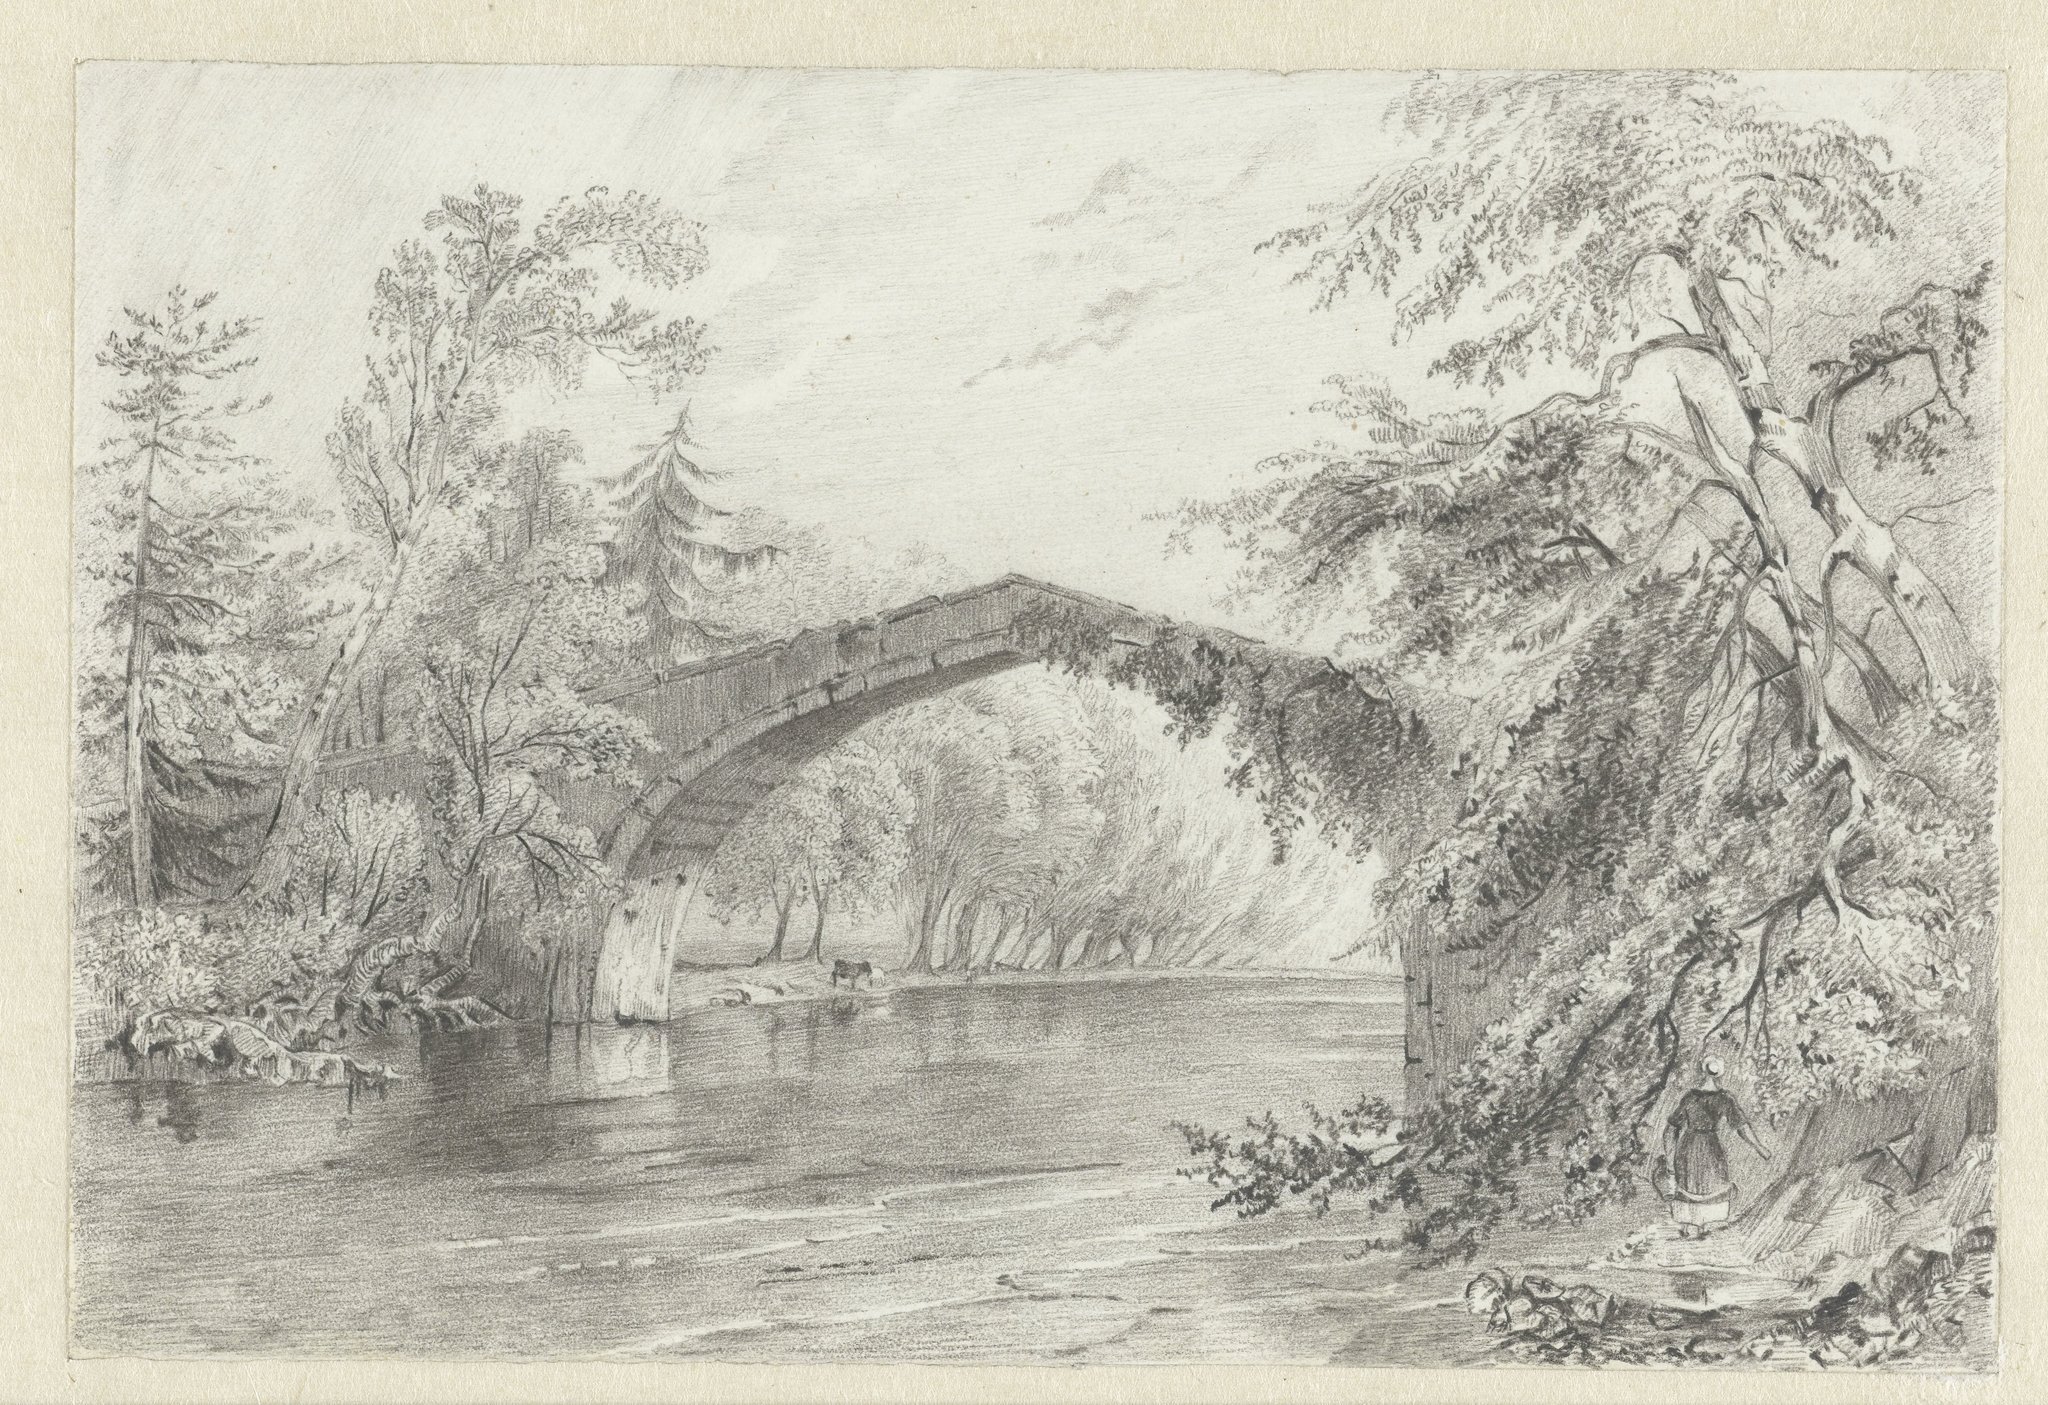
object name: drawing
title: Hoge brug in een park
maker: jan hendrik droste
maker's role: draughtsman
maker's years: 1752-1838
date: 1762-1838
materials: chalk, paper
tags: river, landscape with bridge, viaduct or aqueduct, public gardens, park